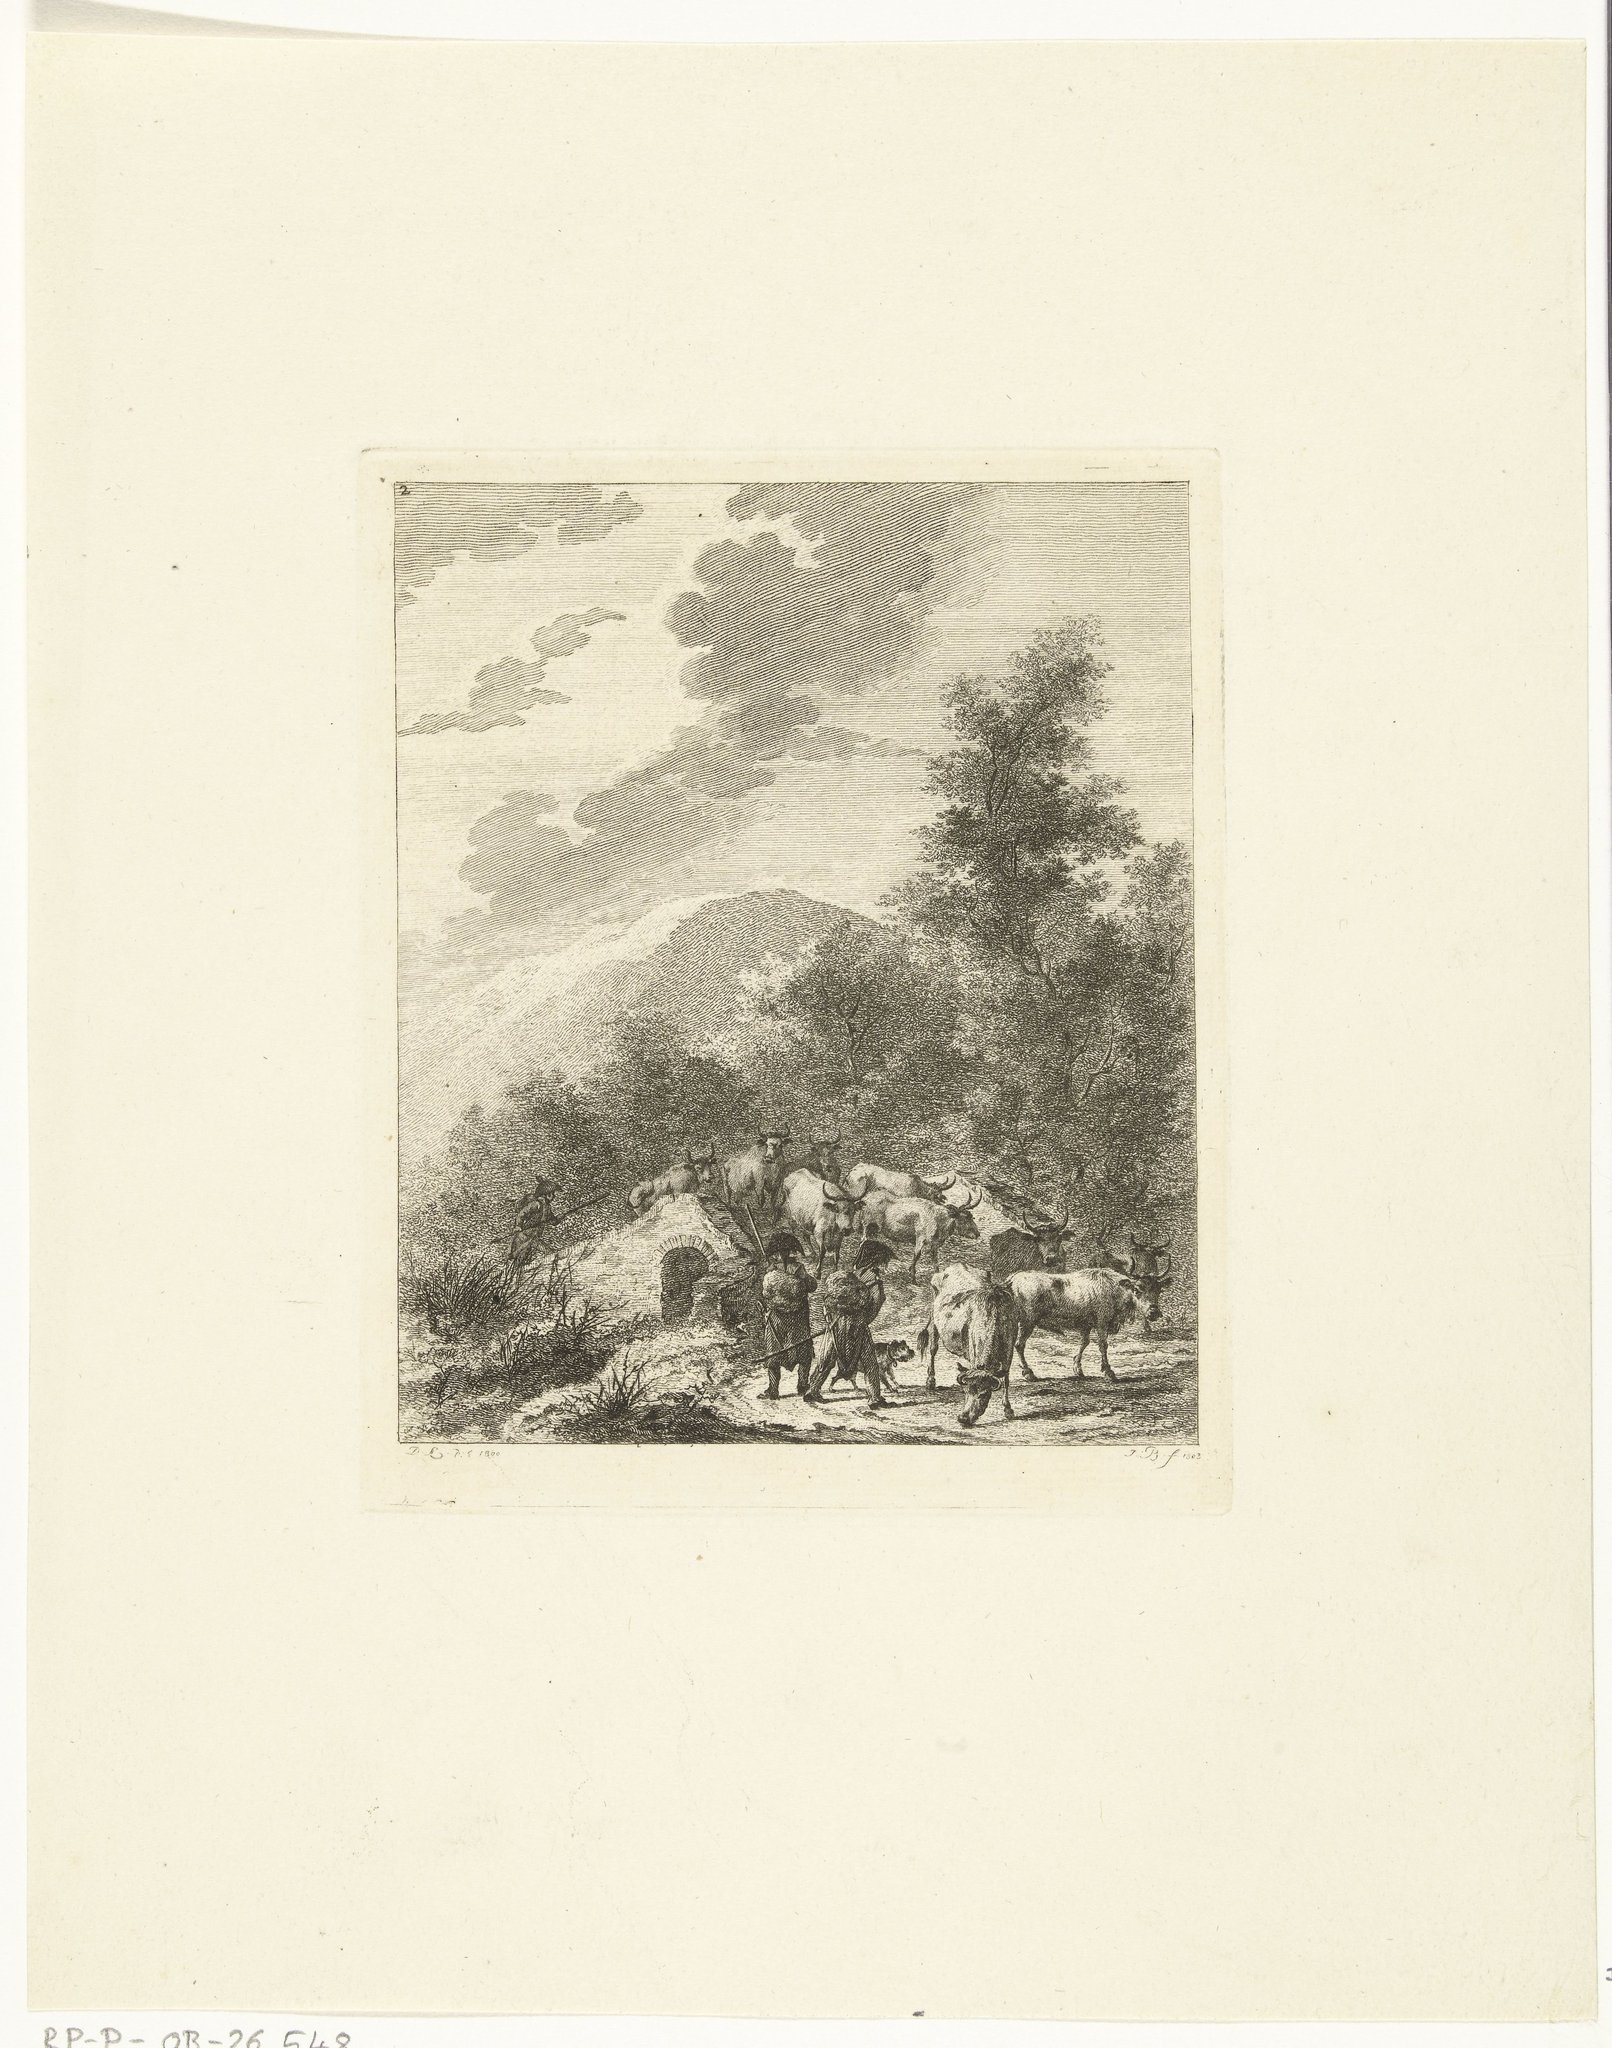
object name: print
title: Soldaten drijven een kudde koeien over een brug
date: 1803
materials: paper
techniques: etching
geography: netherlands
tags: the soldier; the soldier's life, herd, flock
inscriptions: date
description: Landschap met drie Napoleontische soldaten die een kudde koeien over een brug drijven.